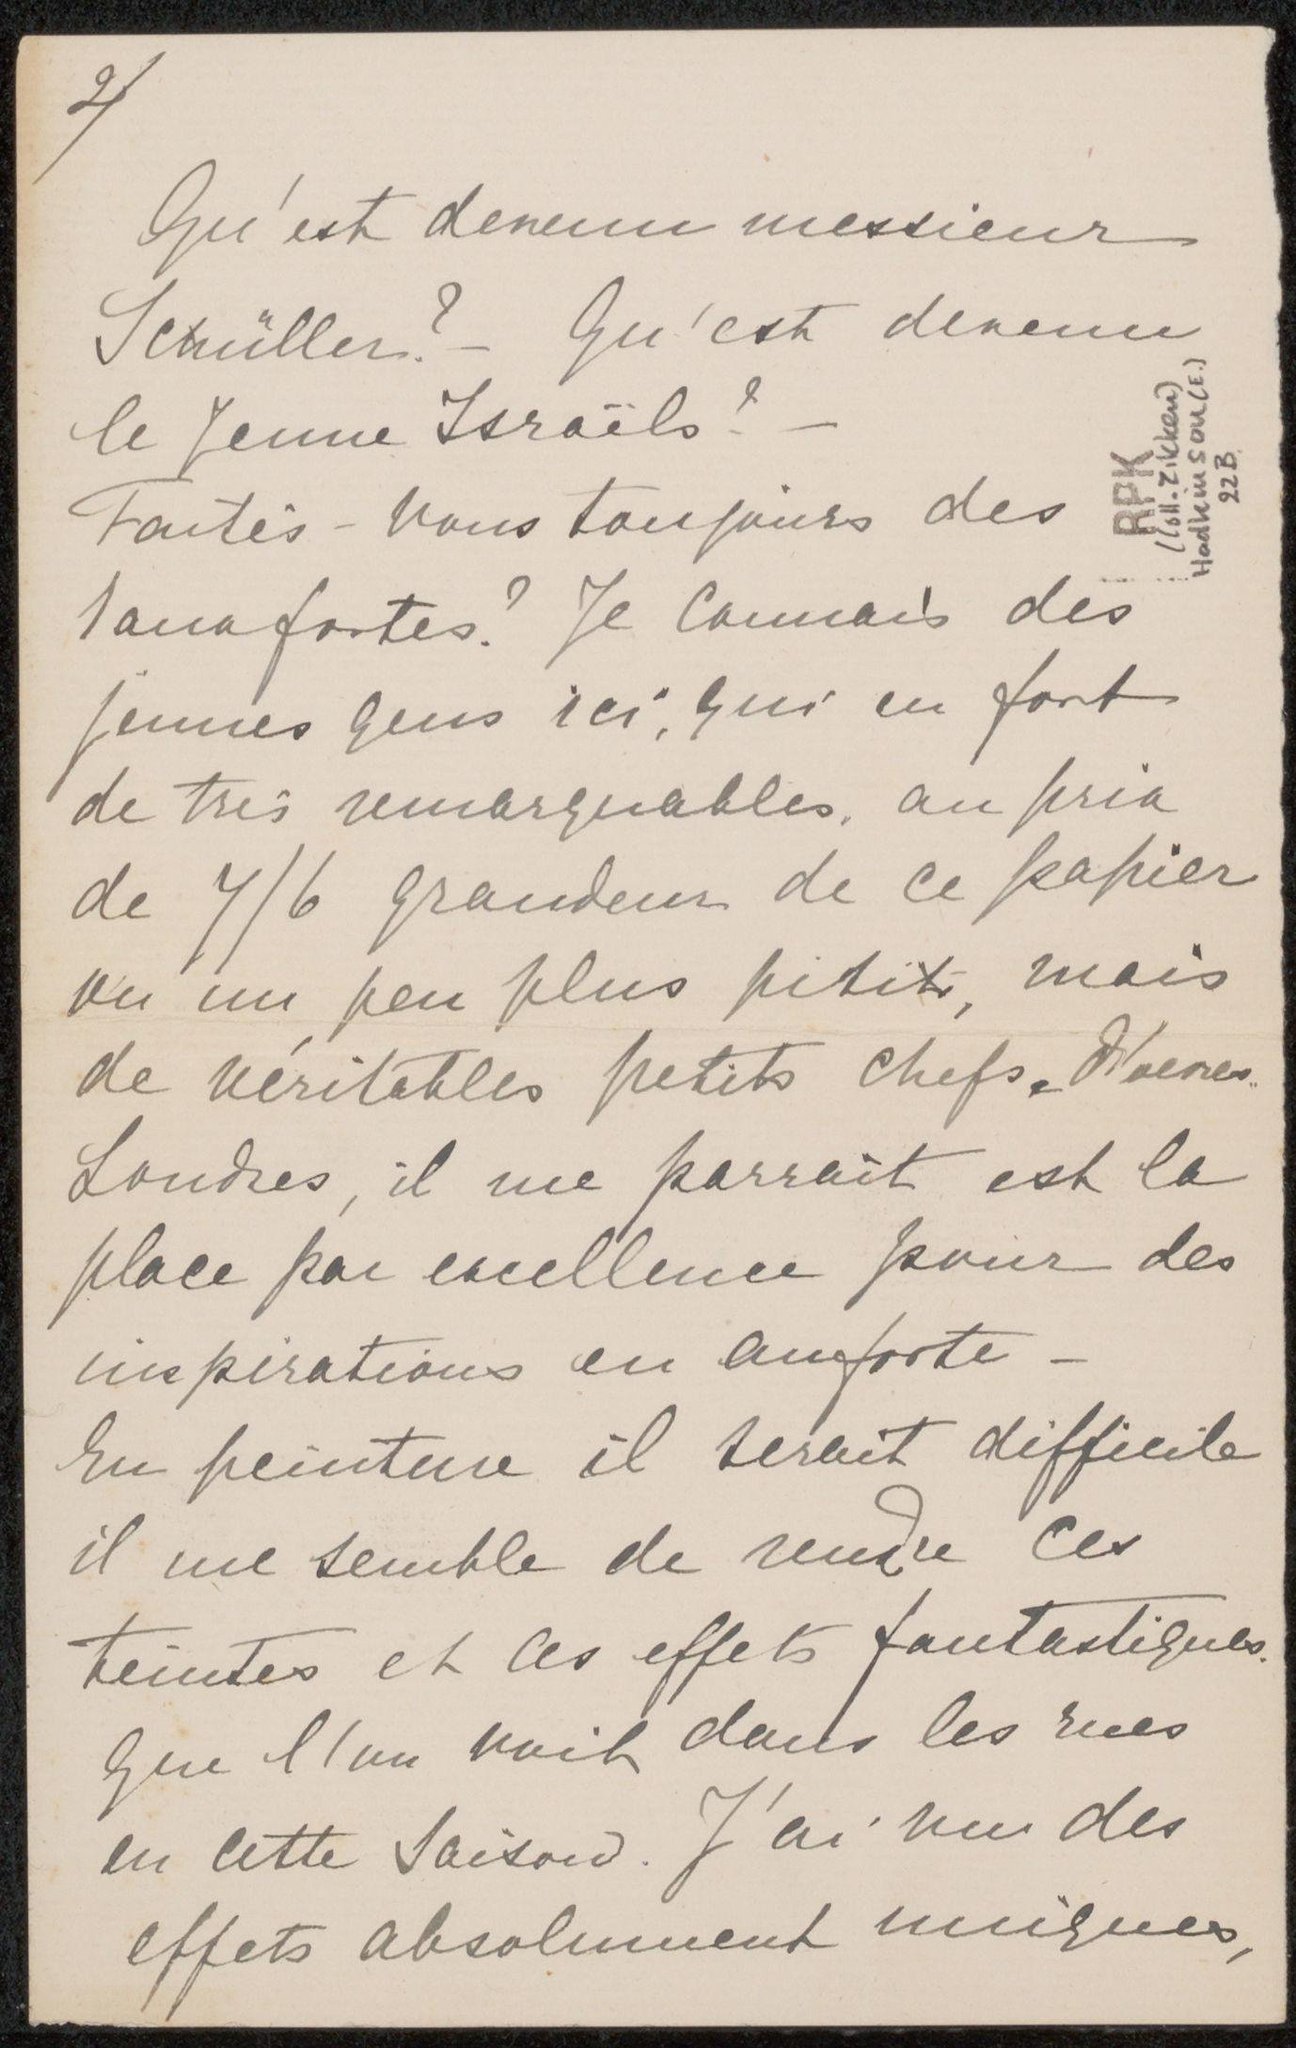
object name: letter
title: Brief aan Philip Zilcken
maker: ernestine hadkinson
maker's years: 1863-1928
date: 1908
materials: ink, paper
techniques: pen, writing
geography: hampstead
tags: amsterdam, isaac israels, liverpool, london, print maker, walter crane, the hague, painter, draughtsman, philip zilcken, the graphic arts, painting (including book-illumination, miniature-painting)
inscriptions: collector's mark: ‘RPK’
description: Vormt samen met RP-D-1982-43-HADKINSON(E.)-22A een doorlopende brief.